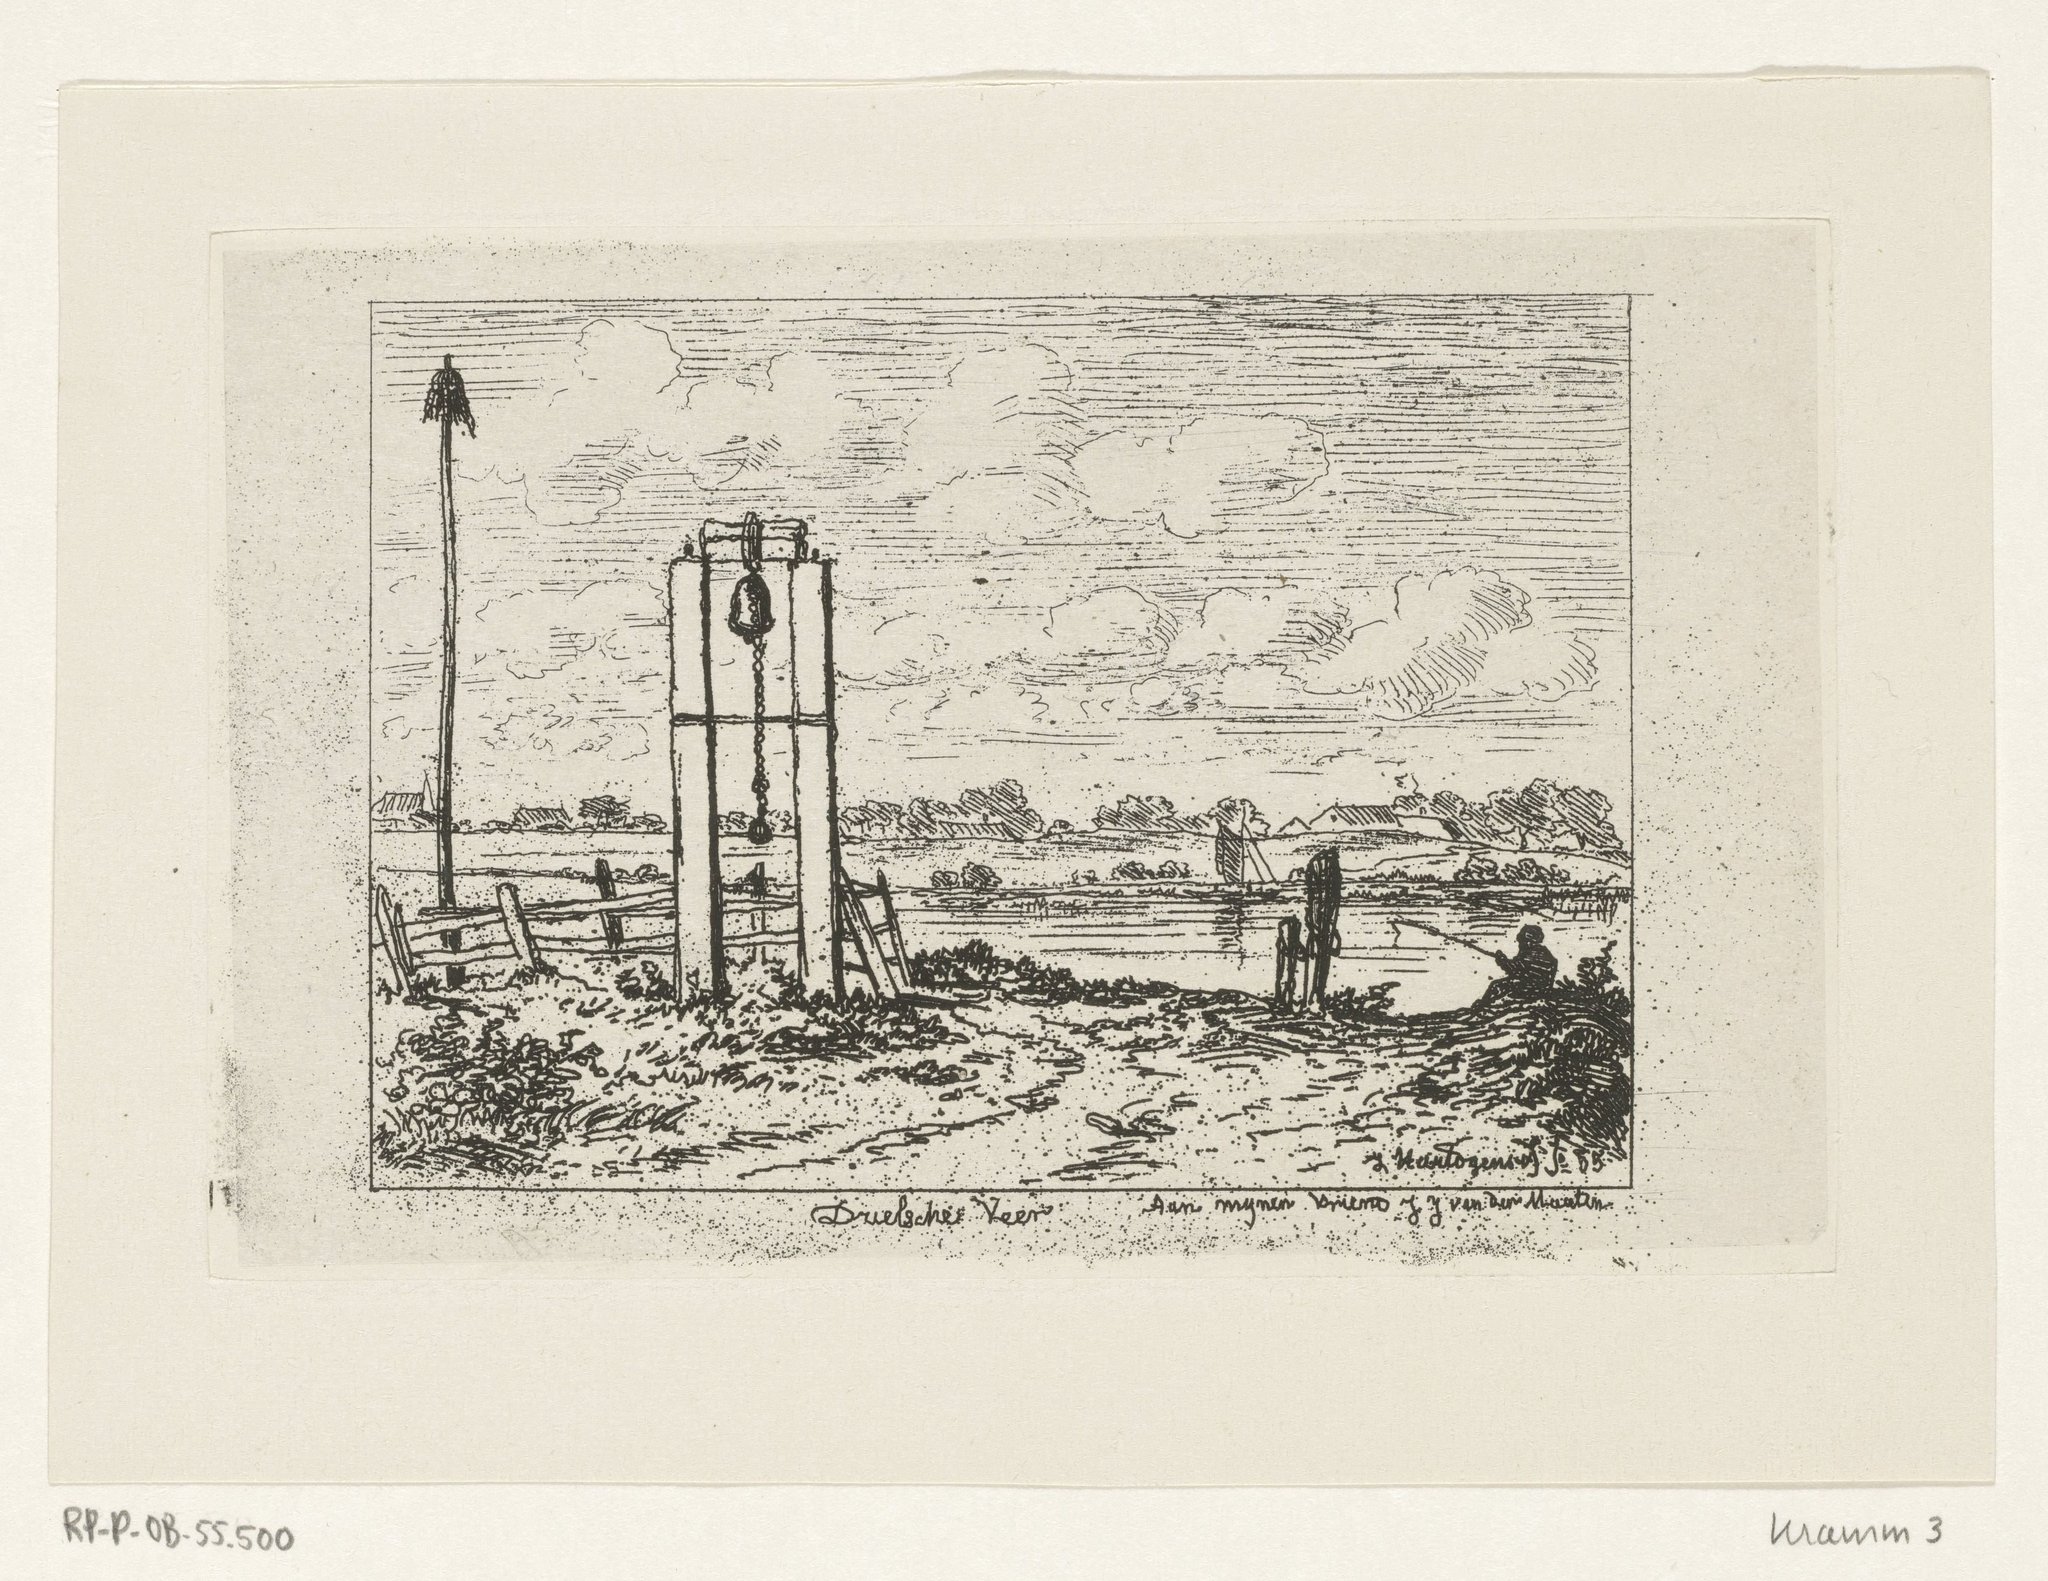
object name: print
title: Bel bij het veer bij Driel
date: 1855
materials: paper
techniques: etching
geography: the hague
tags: landscapes with waters, waterscapes, seascapes (in the temperate zone) (+ landscape with figures, staffage), bell ~ acoustic signalling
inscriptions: collector's mark: Lugt 2228